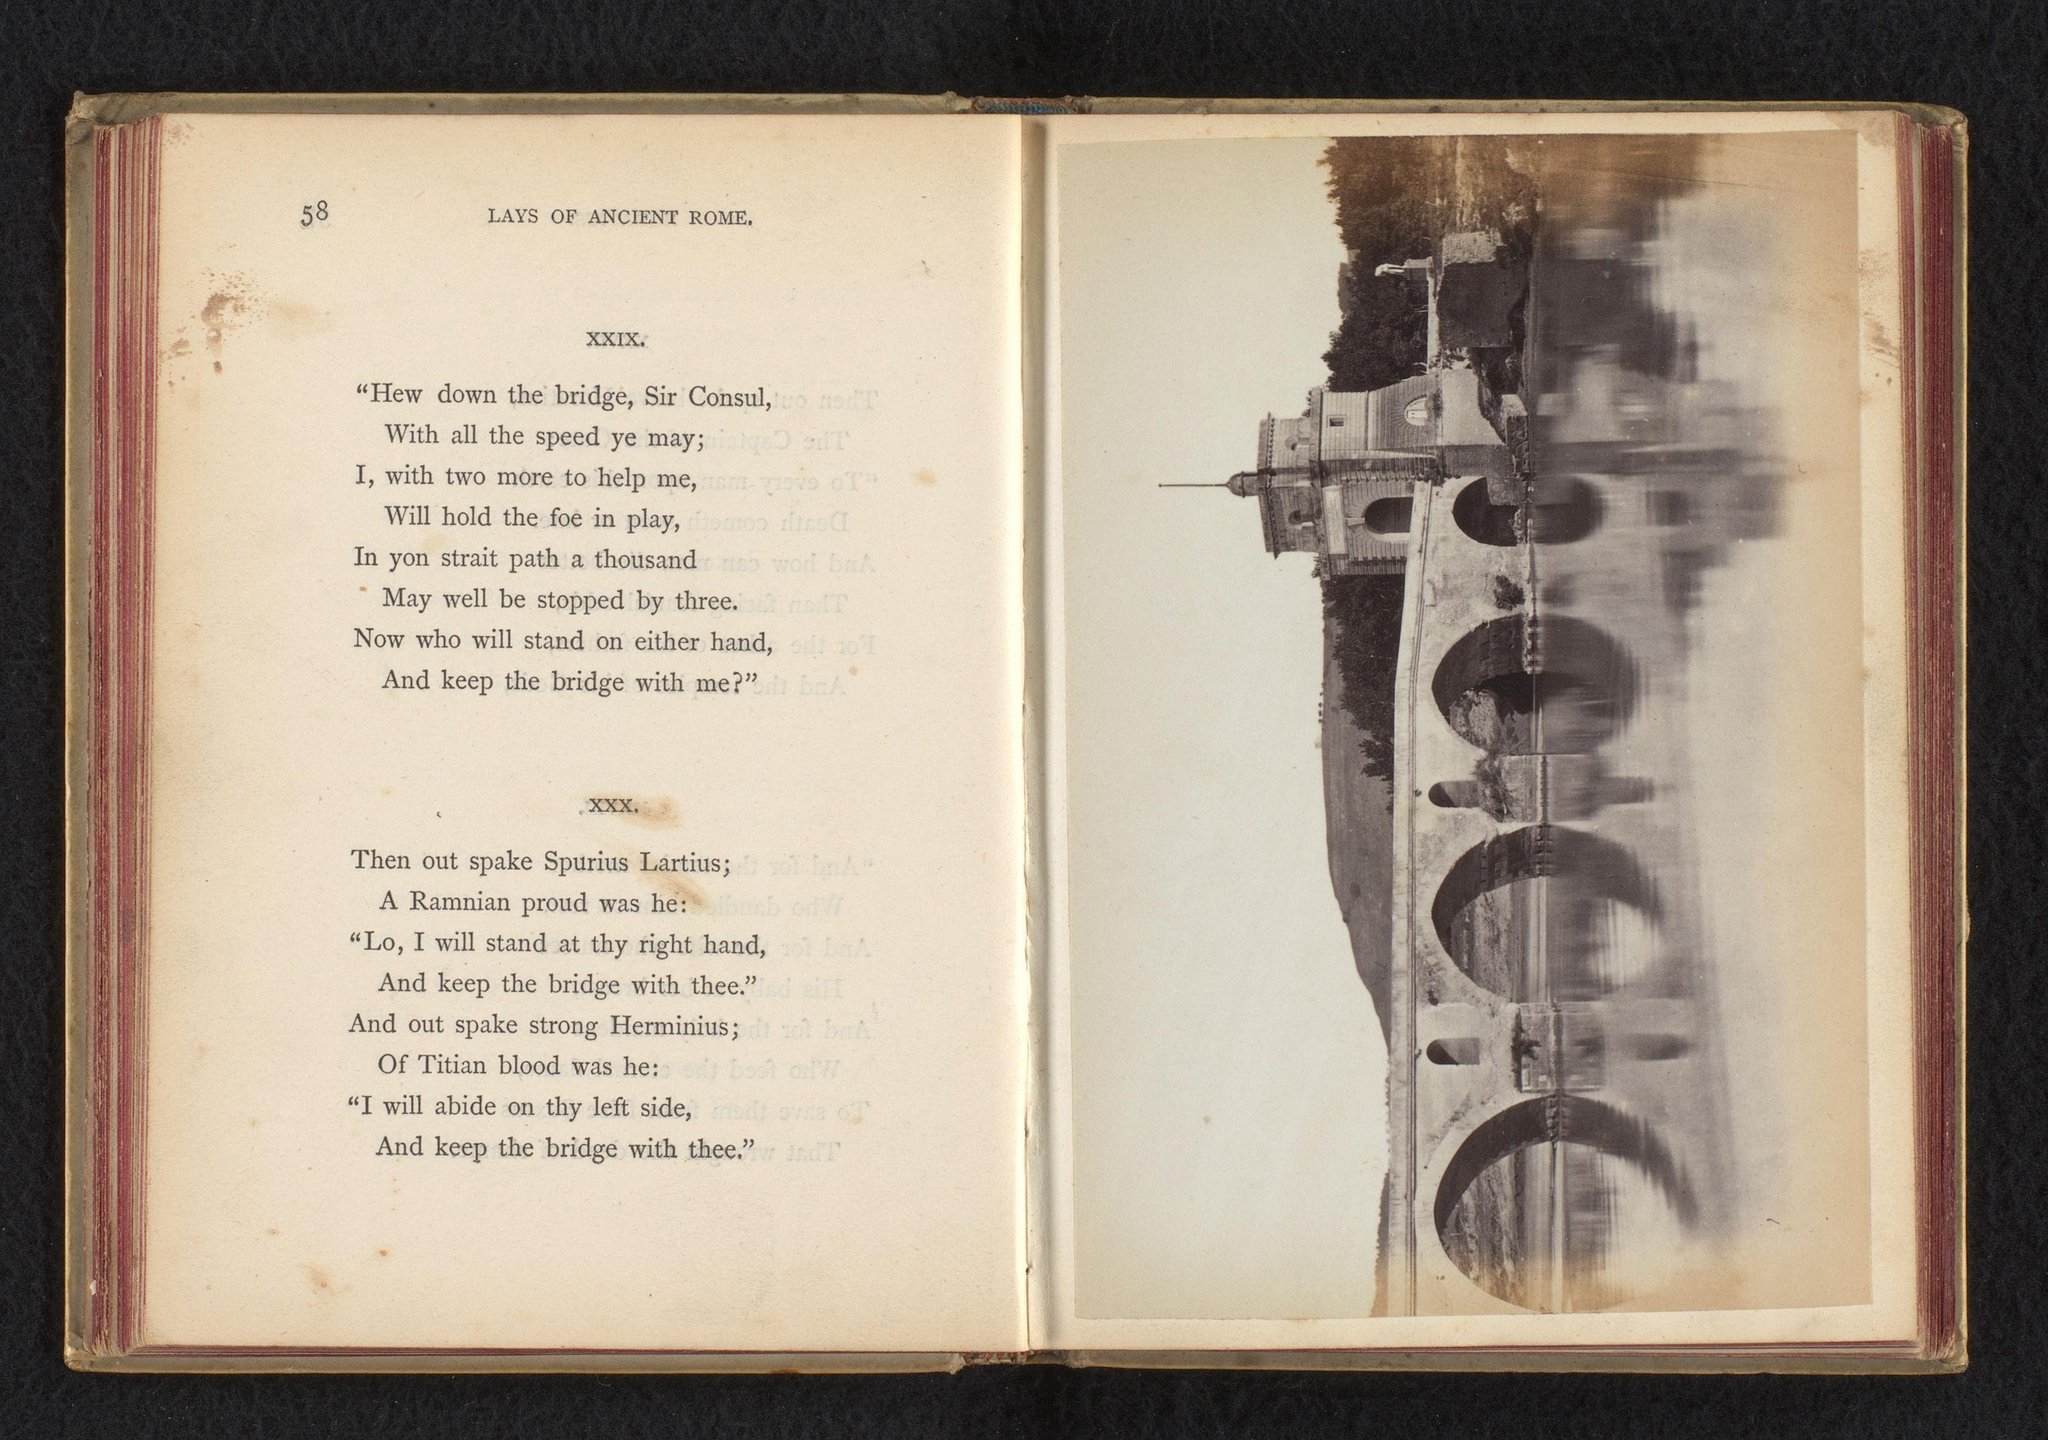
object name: page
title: Milvische Brug over de Tiber, Rome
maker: Anonymous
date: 1851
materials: paper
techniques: albumen print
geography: rome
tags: gate, entrance, bridge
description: Foto op ongenummerde pagina tegenover pagina 58.